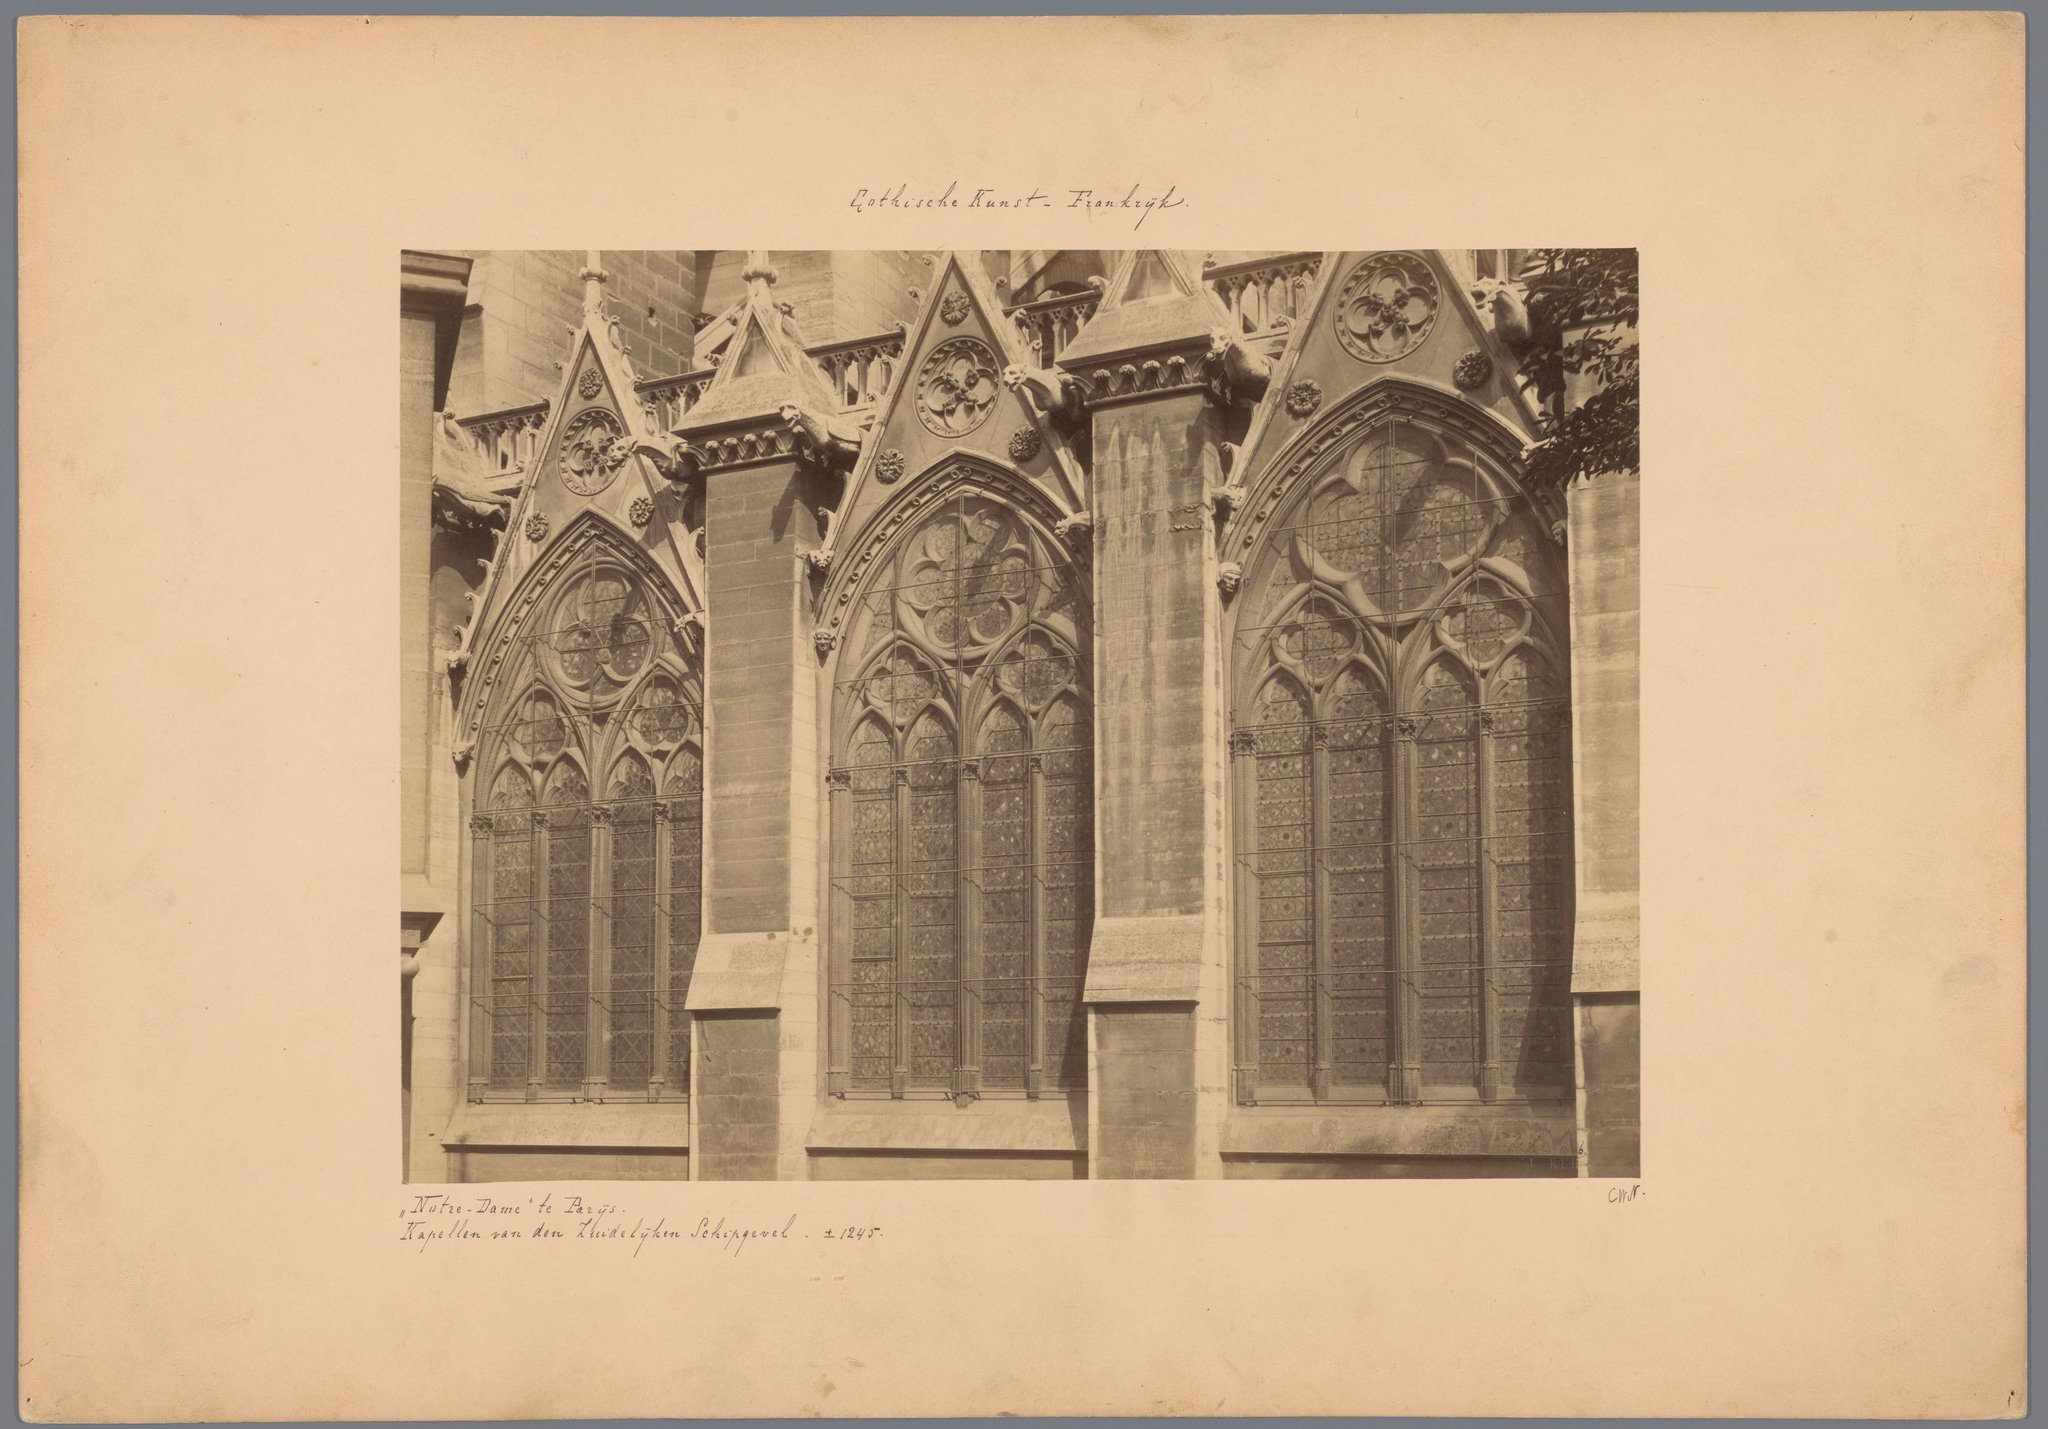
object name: photograph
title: ,,Notre-Dame" te Parijs.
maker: j. kuhn (fotograaf)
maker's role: fotograaf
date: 1875-1900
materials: cardboard, photographic support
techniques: albumen print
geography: paris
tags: church-window, e.g. rose-window, parts of church exterior and annexes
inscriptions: collector's mark: ‘KUNSTNIJVERHEIDSCHOOL QUELLINUS AMSTERDAM FRANS HALSSTRAAT 14.’, inscription: ‘CWN.’, number: ‘6.’, collector's mark: ‘INSTITUUT VOOR KUNST-NIJVERHEIDSONDERWIJS GABRIËL METSUSTRAAT No. 16 AMSTERDAM’, name: ‘J. Kuhn’, inscription: ‘Gothische Kunst - Frankrijk.’